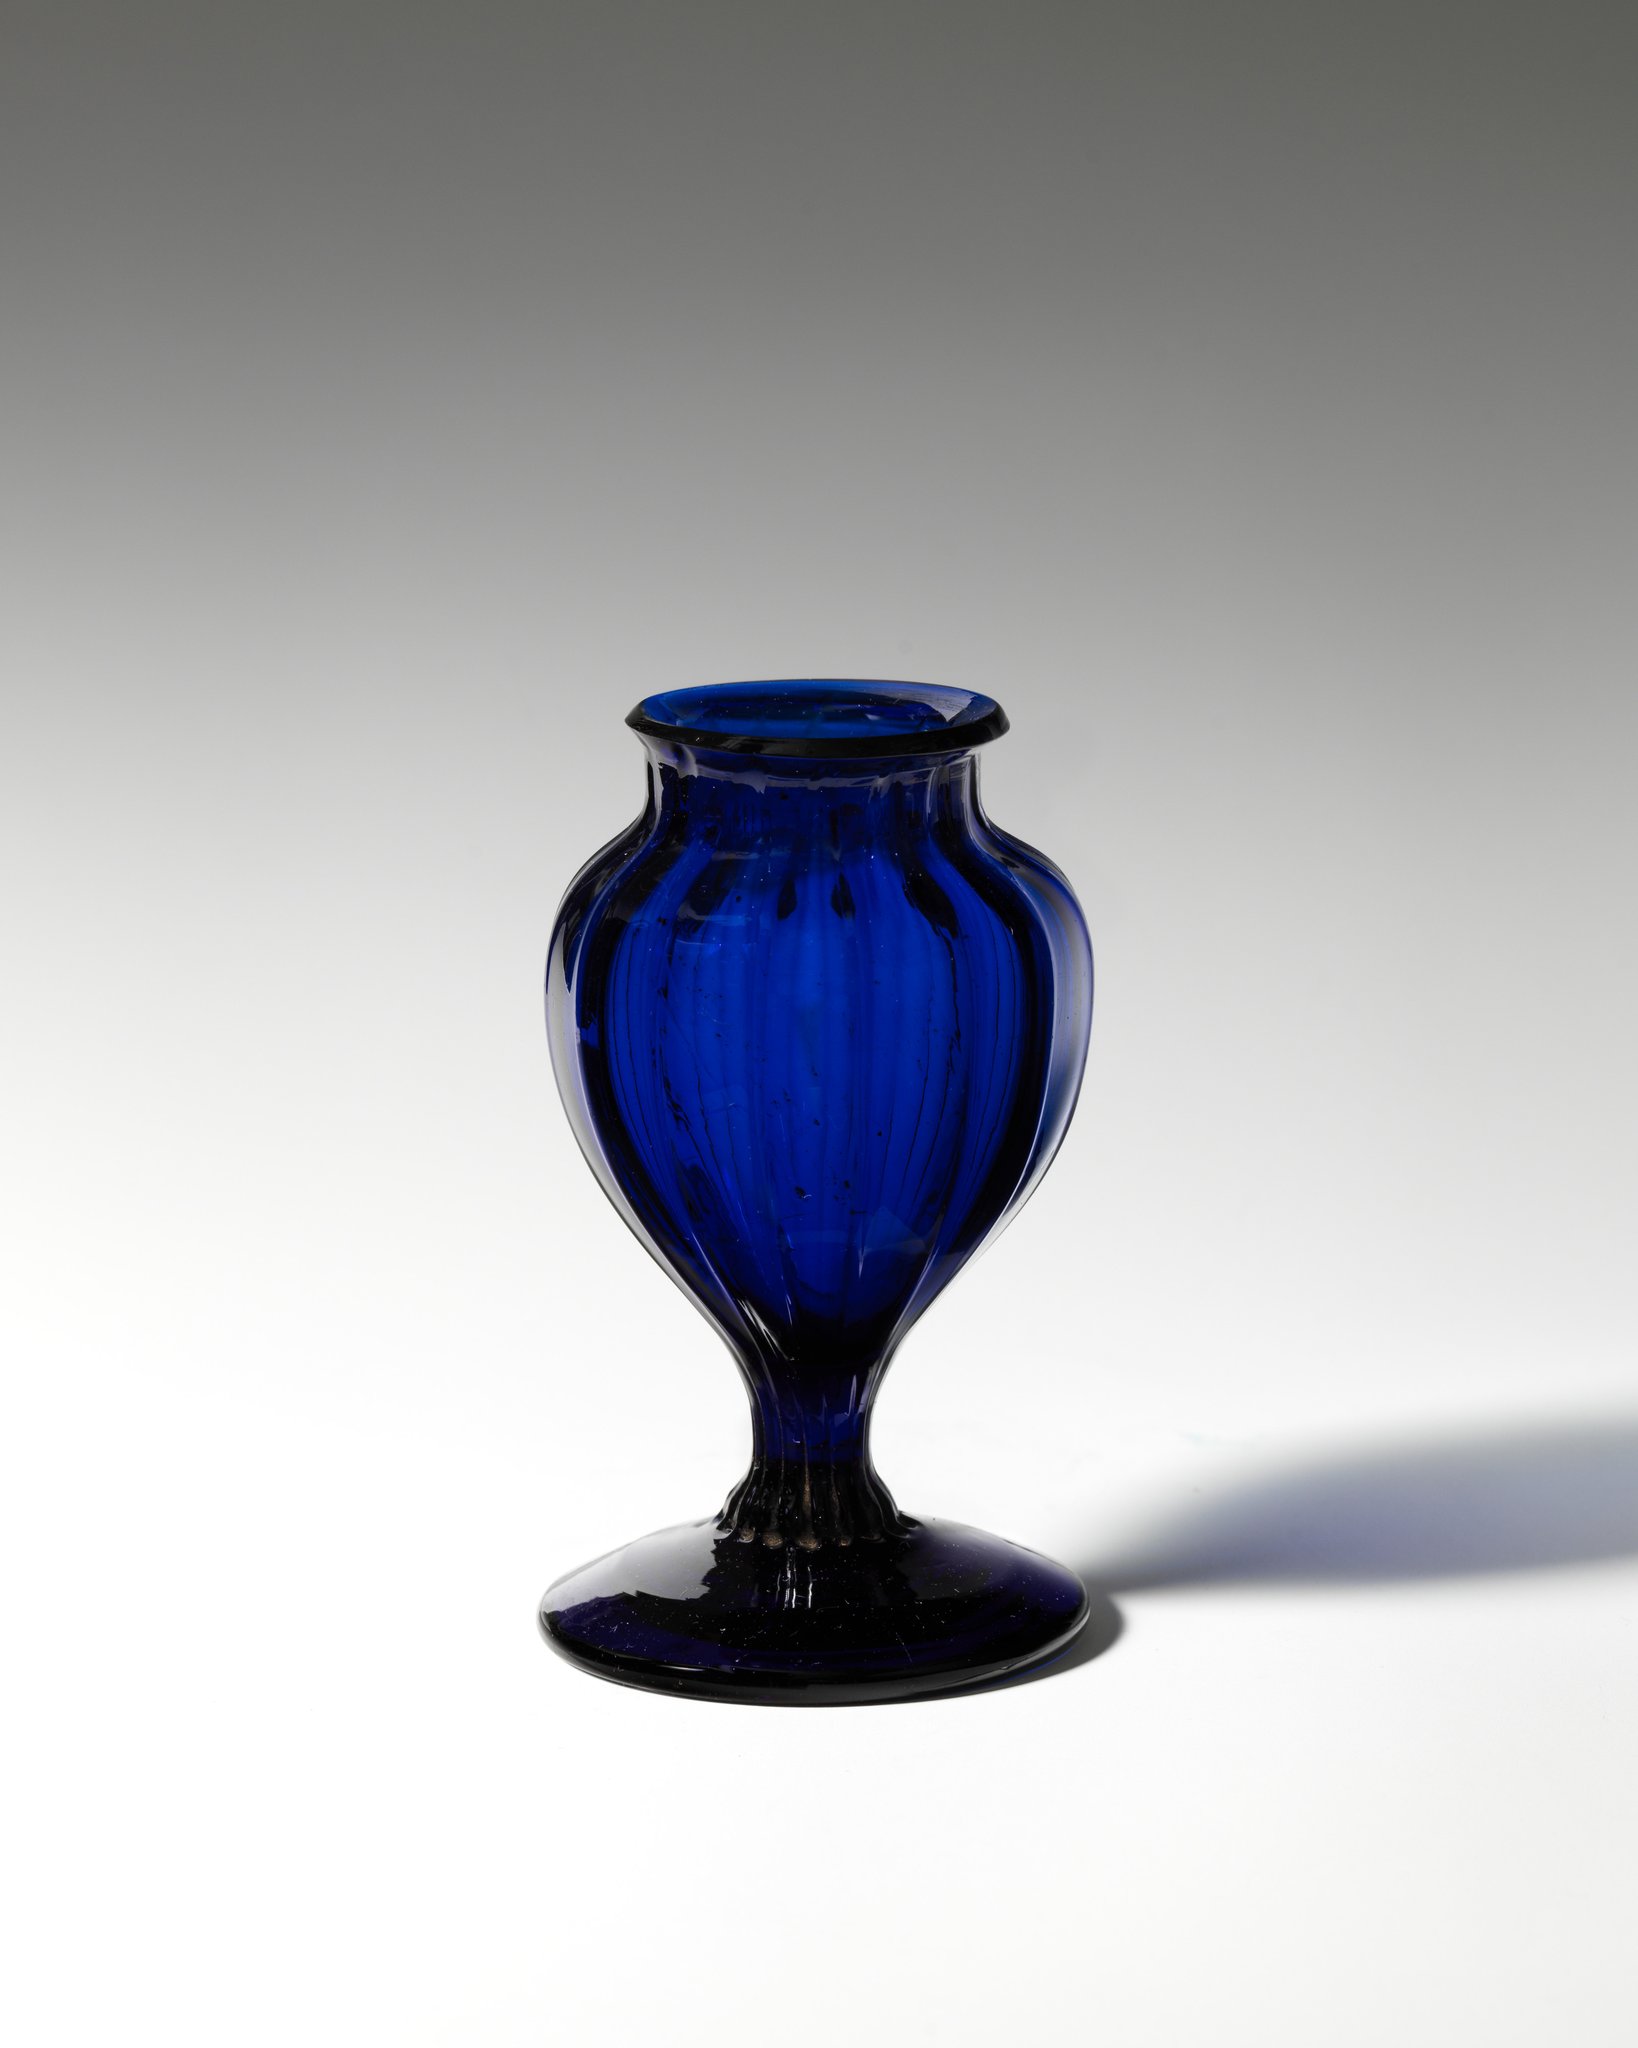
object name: vase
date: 1701-1800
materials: glass